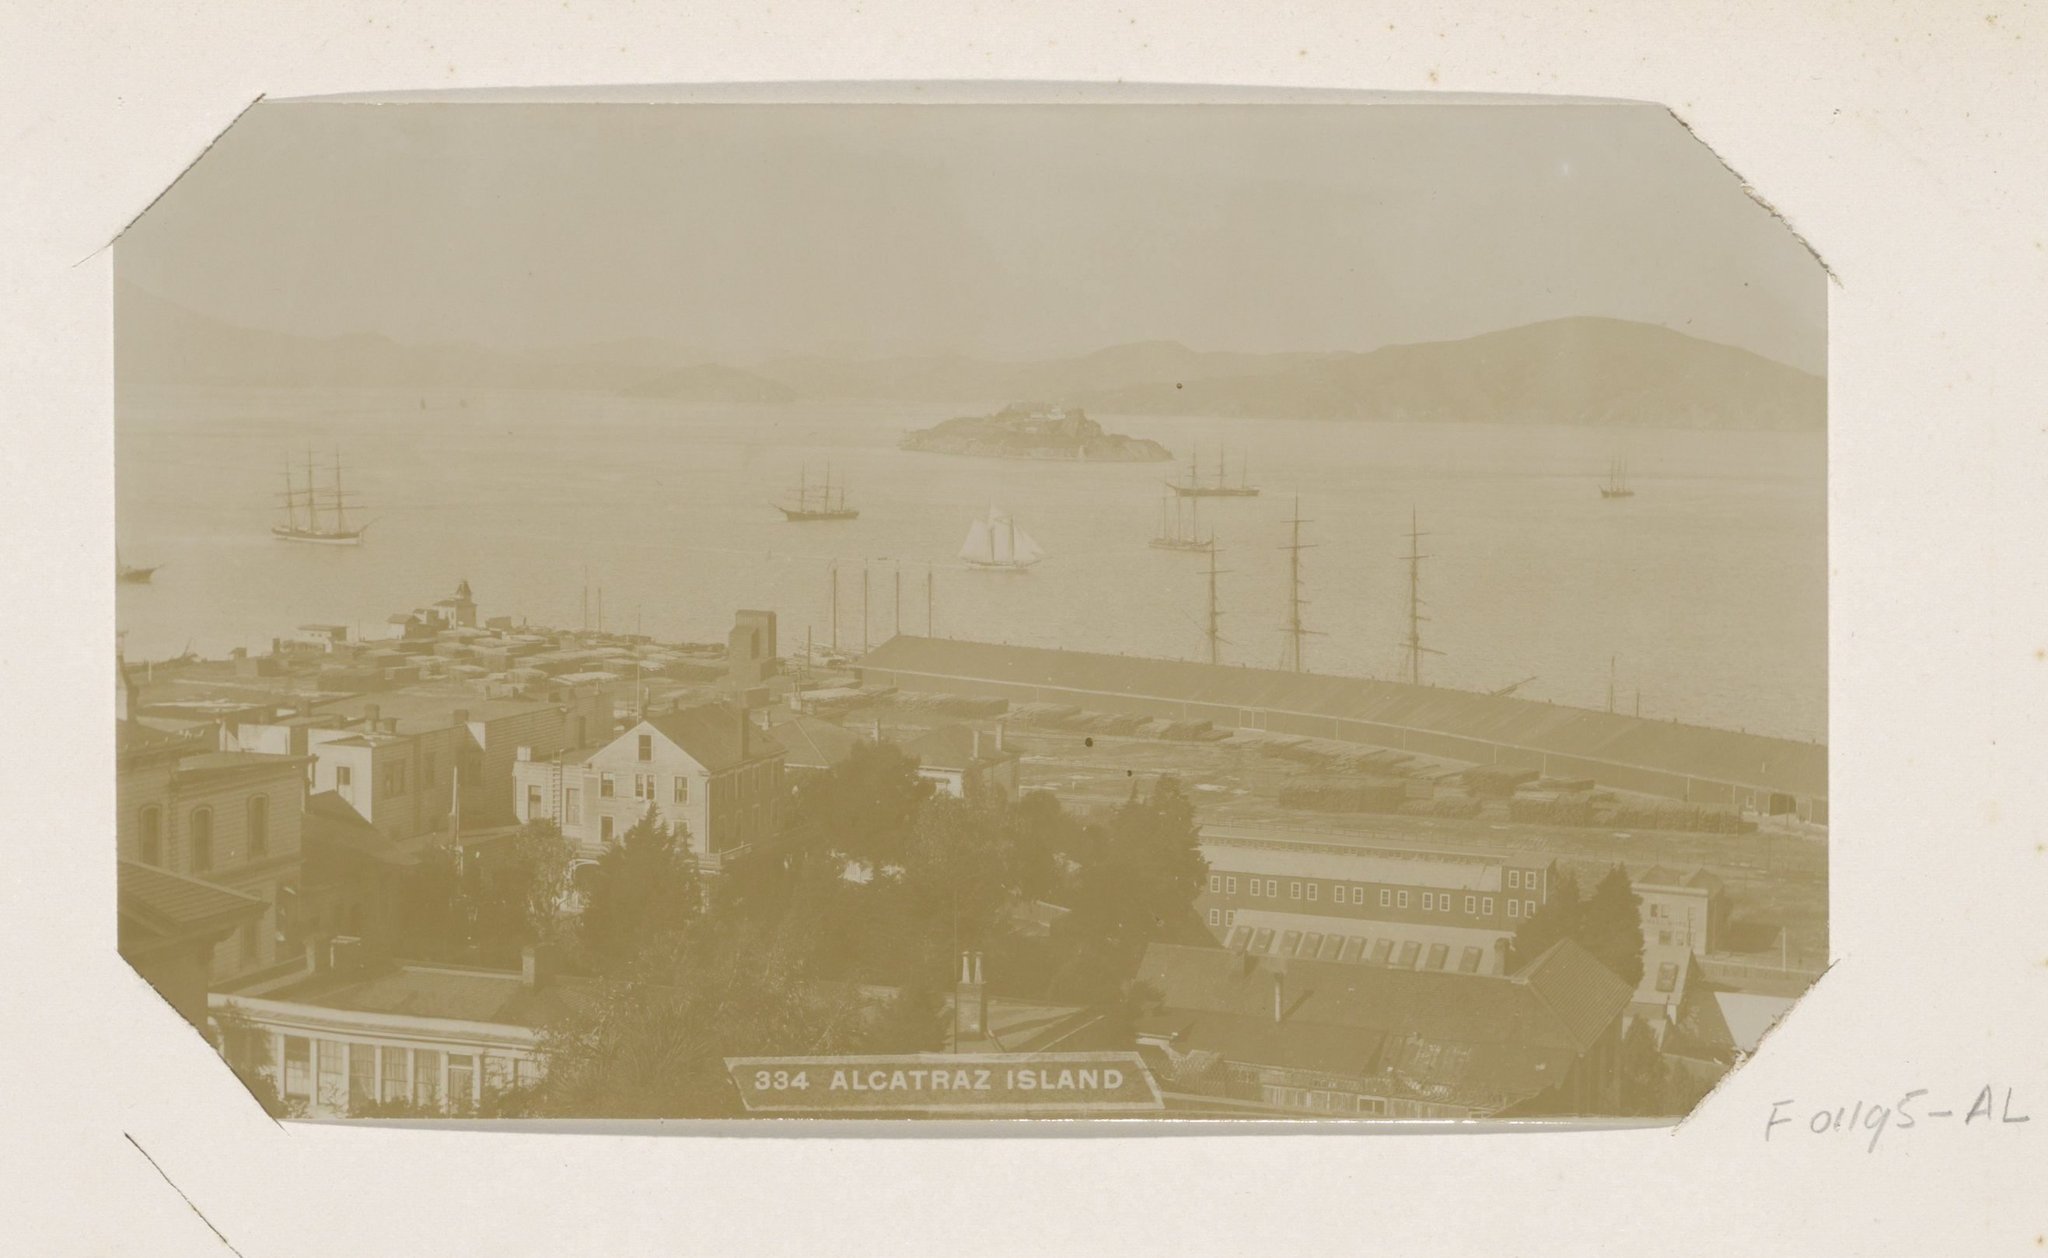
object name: photograph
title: Alcatraz Island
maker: Anonymous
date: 1860-1900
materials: cardboard, paper, photographic support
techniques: gelatin silver print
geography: san francisco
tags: prison, jail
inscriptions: negative number: ‘334’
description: Onderdeel van Fotoalbum van een reis door de Verenigde Staten, Honolulu, Nederlands-Indië, Aden, Zanzibar en Zuidelijk Afrika.